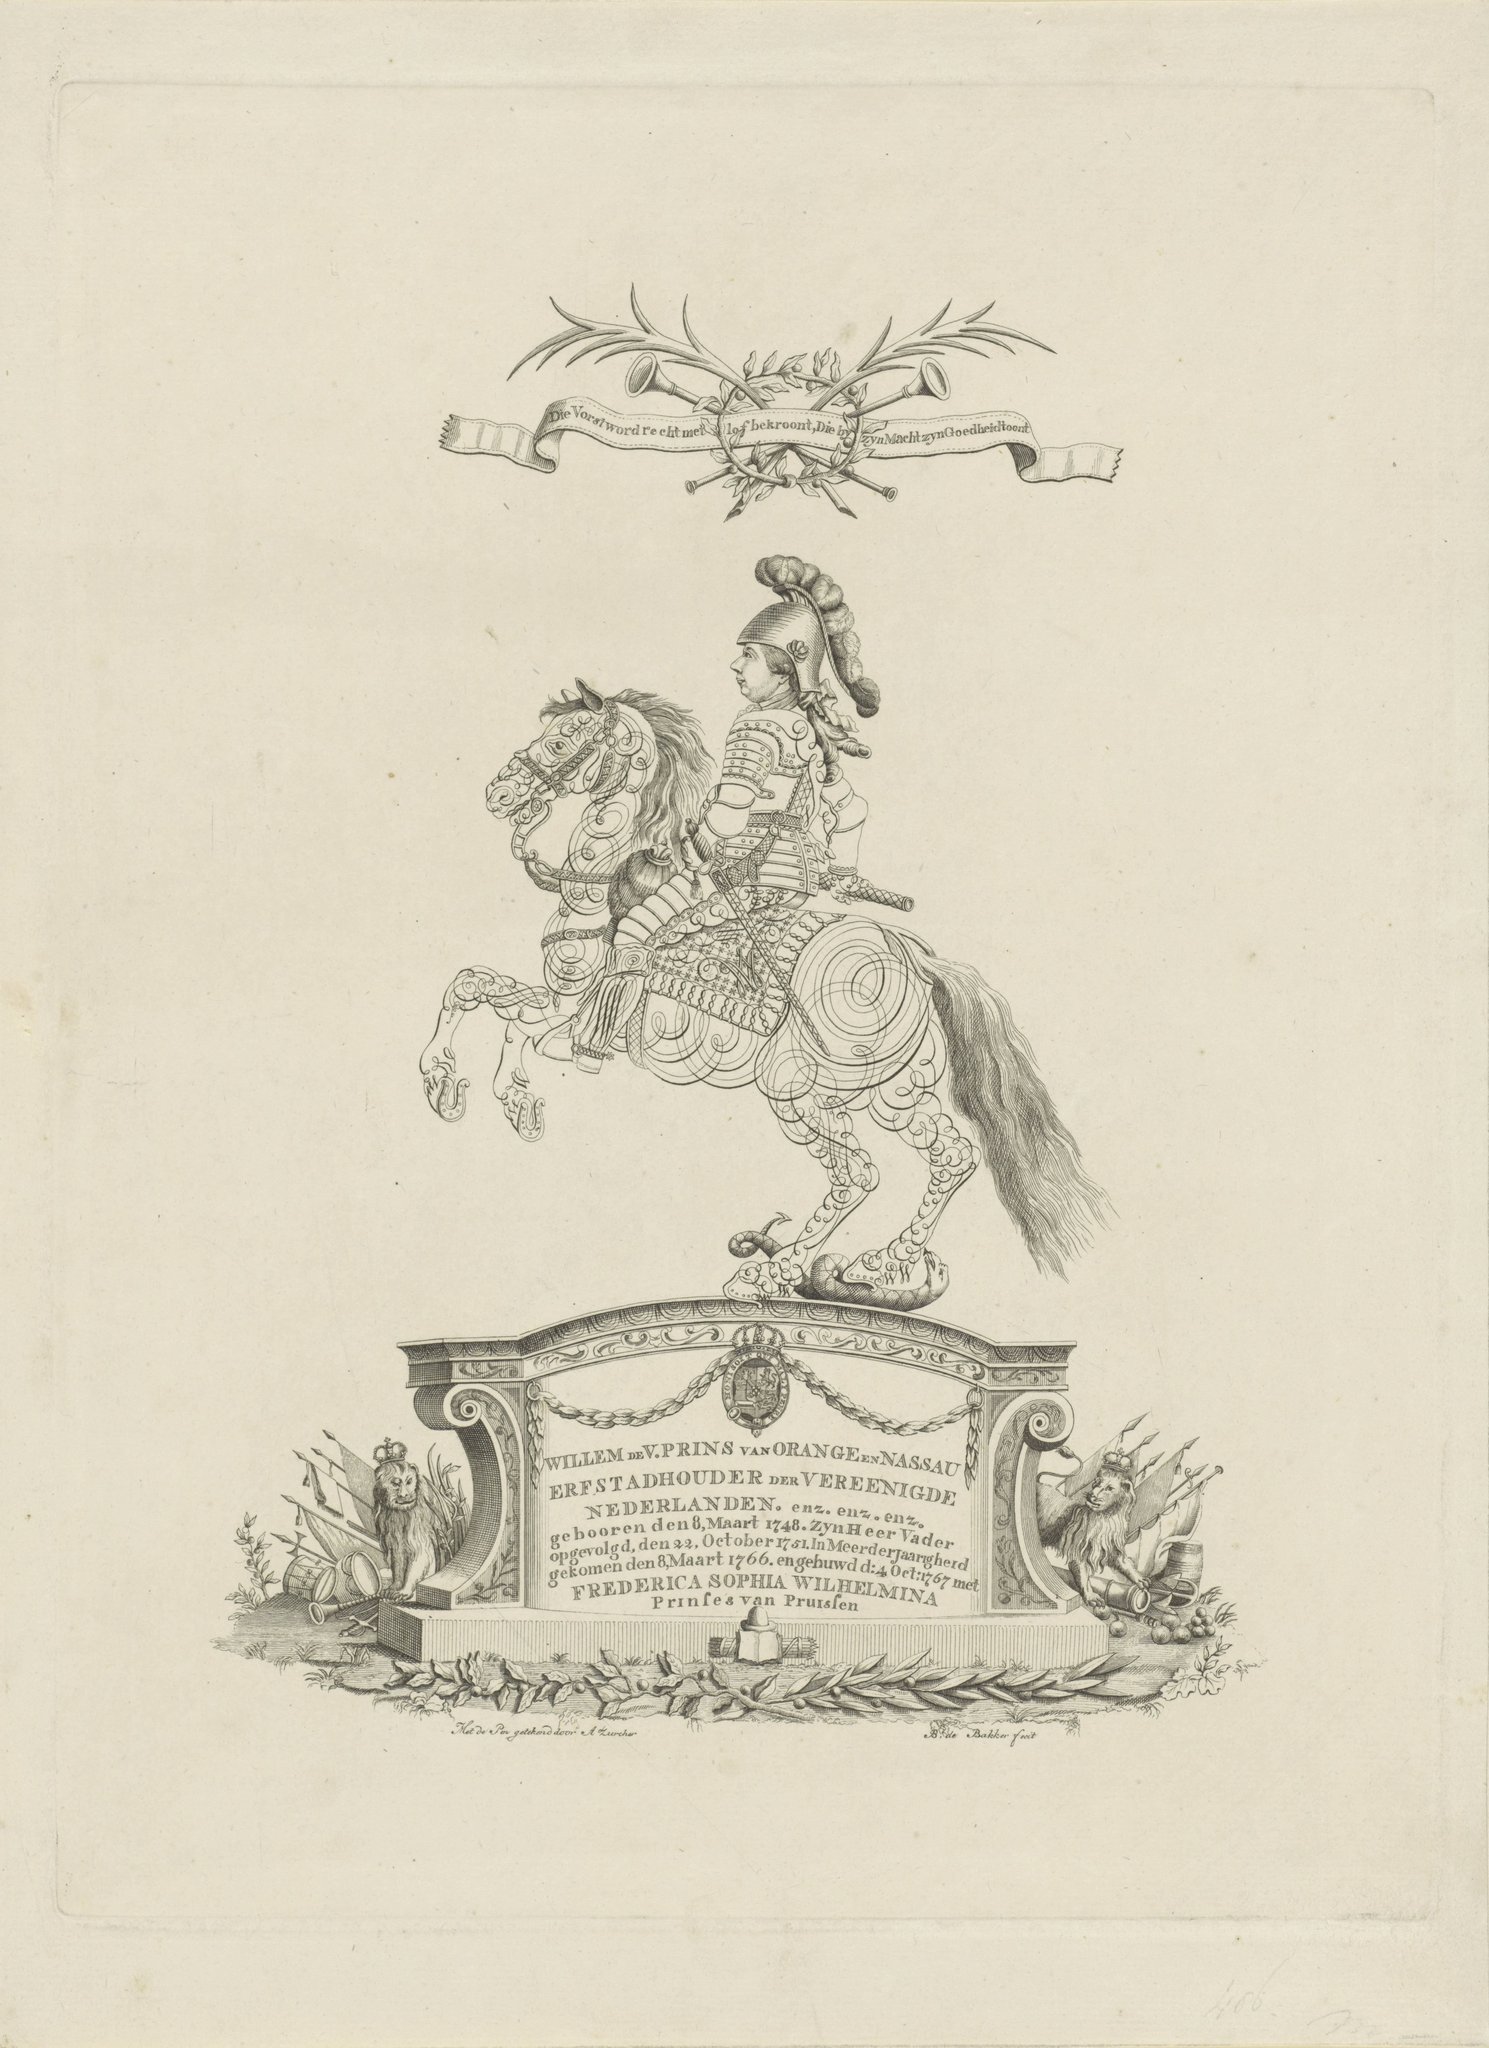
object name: print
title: Ruiterstandbeeld van Willem V, prins van Oranje-Nassau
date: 1775-1805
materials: paper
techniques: engraving, etching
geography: amsterdam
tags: william v (prince of orange), knighthood order (garter) - insignia of a knighthood order, e.g.: badge, chain, equestrian statue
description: Ruiterstandbeeld van Willem V. In zijn rechterhand een commandostaf. Rondom liggen meerdere allegorische objecten. Op een banderol een regel Nederlandse tekst. Op een voetstuk acht regels Nederlandse tekst en zijn wapen met een kroon, gedecoreerd met de Kousenband en het devies van de Orde van de Kousenband.